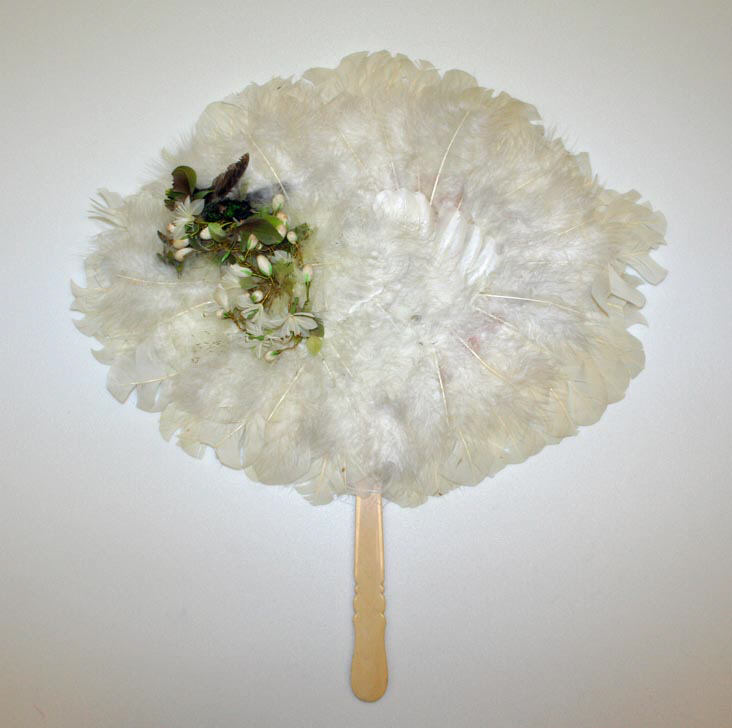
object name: fan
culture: brazilian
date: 1885-1890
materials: feather, ivory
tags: flowers